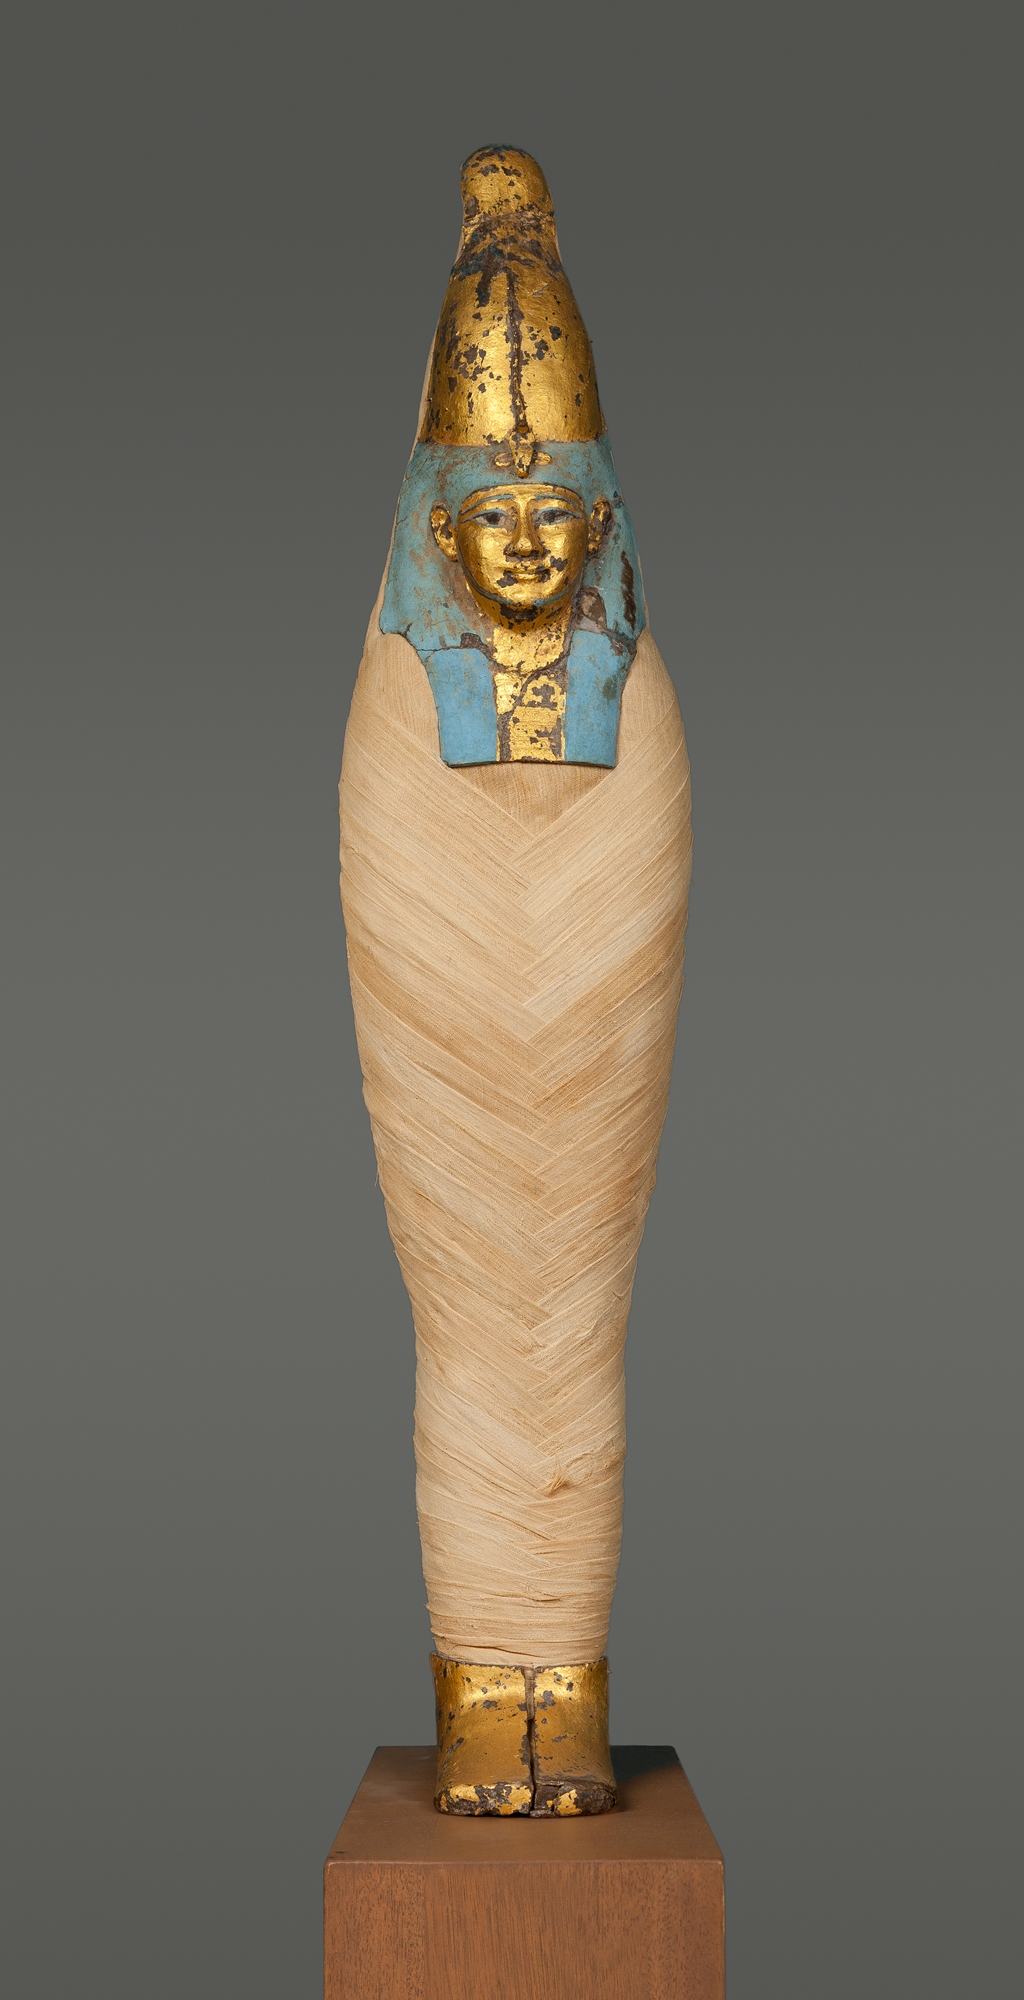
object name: mask, foot cover, osiride figure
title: Mask and Foot Cover of "Corn Mummy"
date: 400-250 BCE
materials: linen, wax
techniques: gilding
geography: egypt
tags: mummies